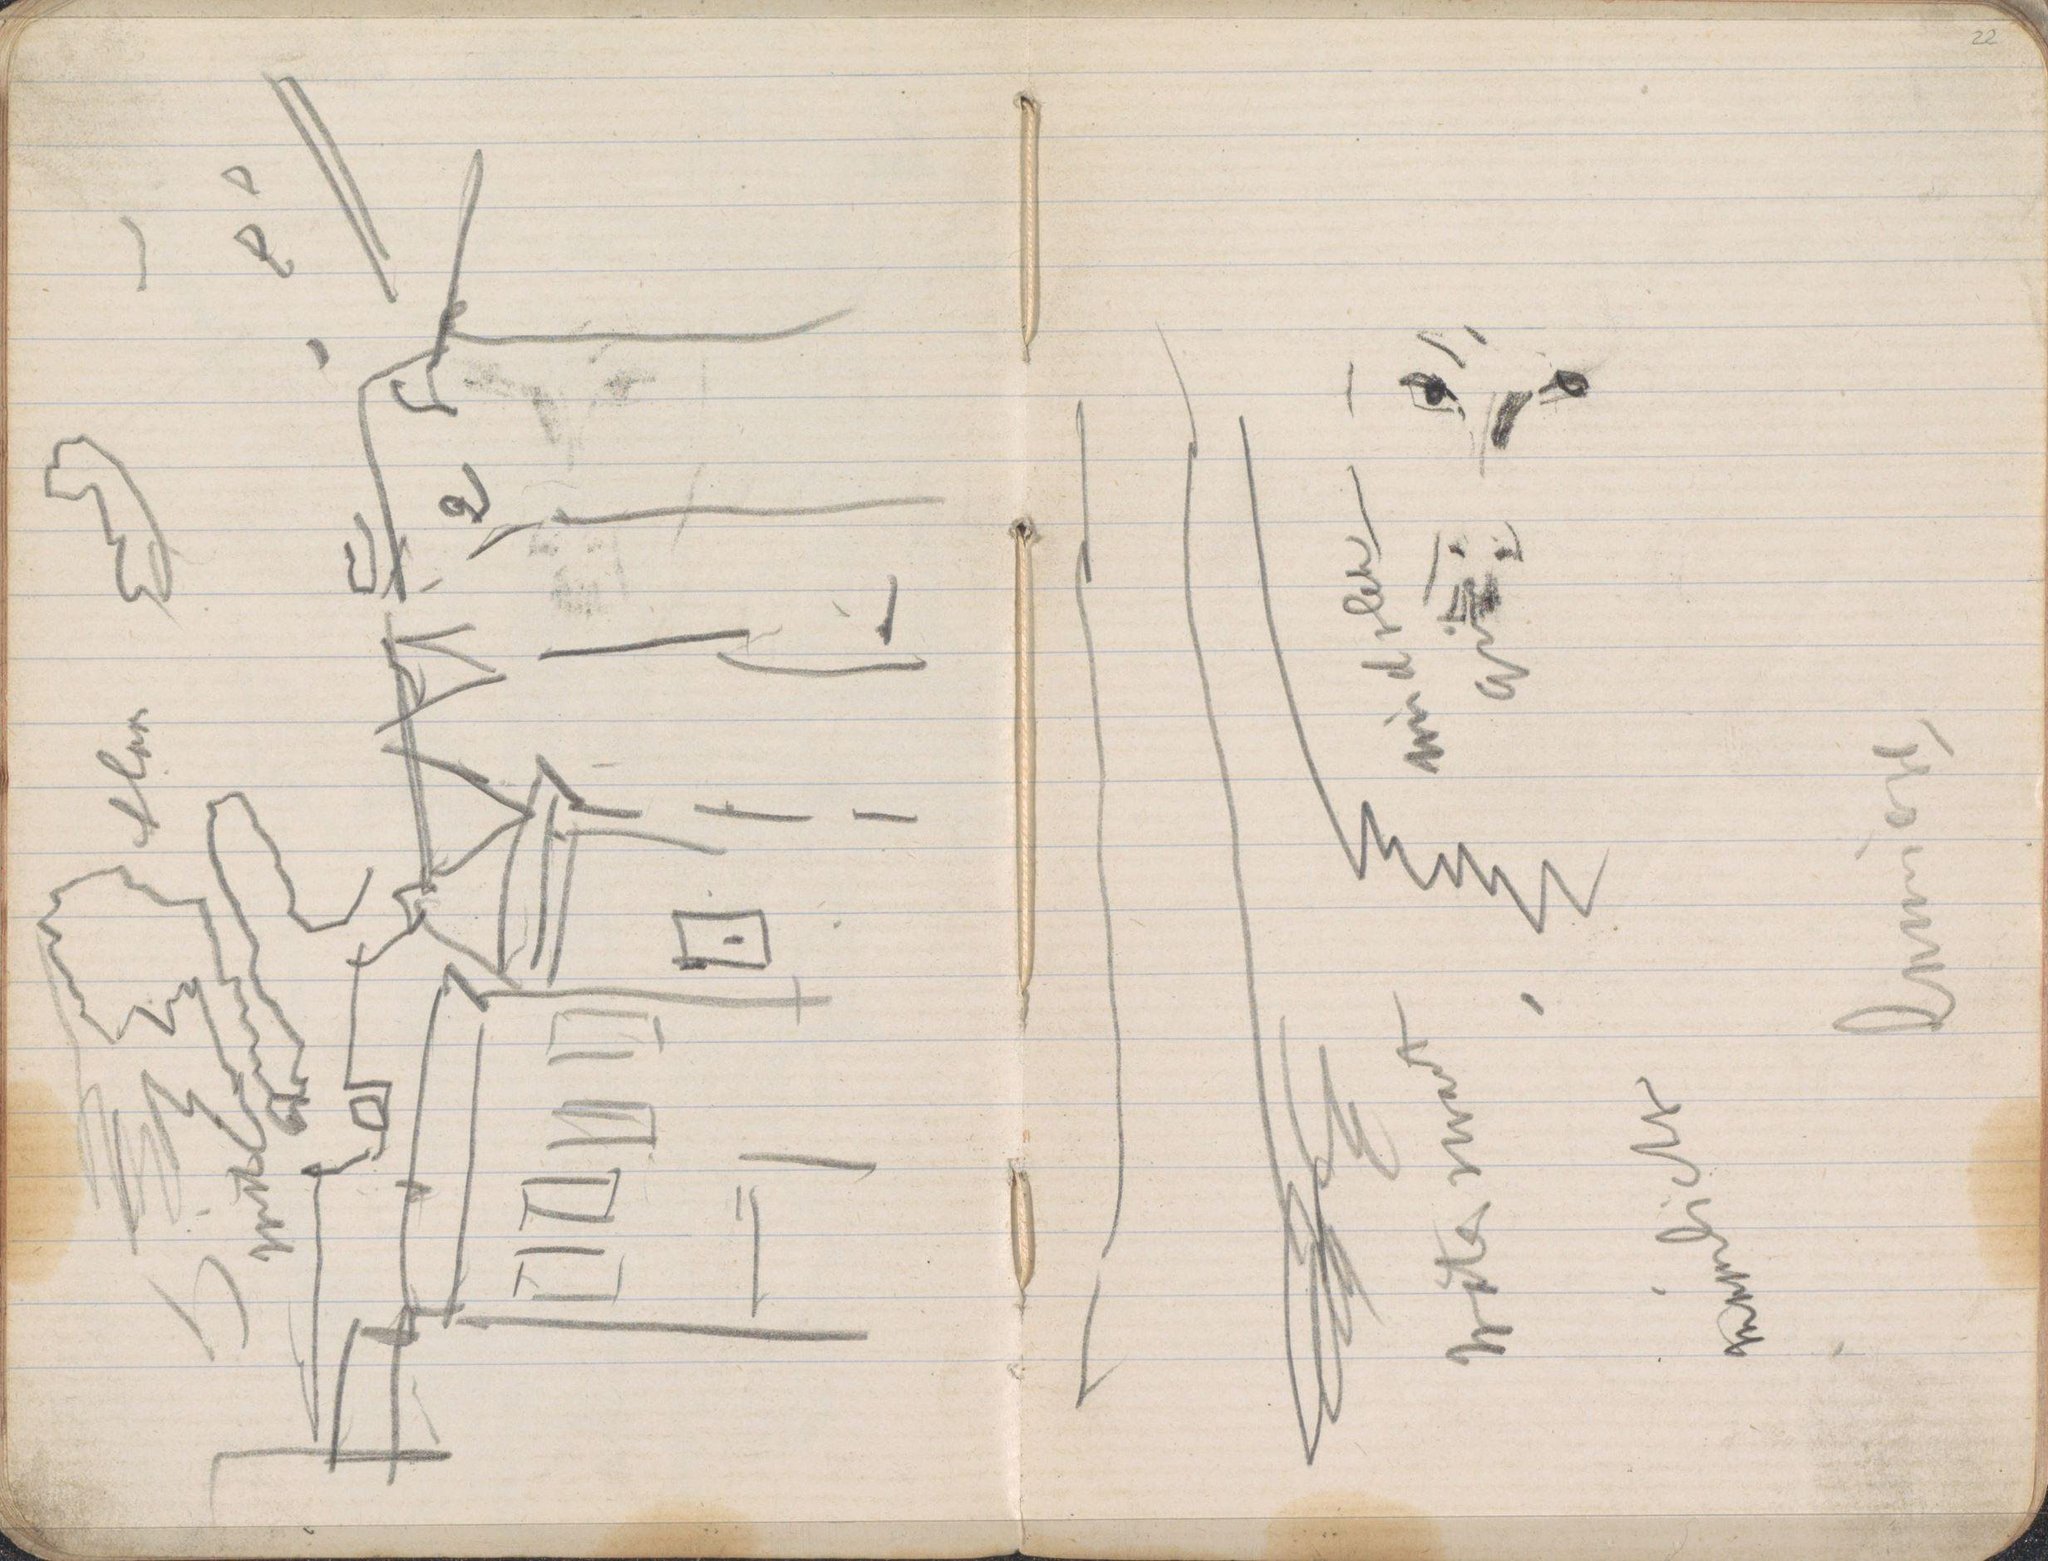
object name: sketchbook leaf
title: Gezicht op de Lauriergracht te Amsterdam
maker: george hendrik breitner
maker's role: draughtsman, painter, print maker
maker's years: 1857-1923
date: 1896-1901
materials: chalk, pencil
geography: amsterdam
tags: face, canals, waters (in city), civic architecture; edifices; dwellings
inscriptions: annotation: ‘maanlicht/ lumière’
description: Lauriergracht 7 en hoger. Mogelijk gezien vanaf brug 112 in de Prinsengracht naar Lijnbaansgracht. Verder een studie van een gezicht. Pagina 21 en pagina 22 uit een schetsboek met 37 bladen.